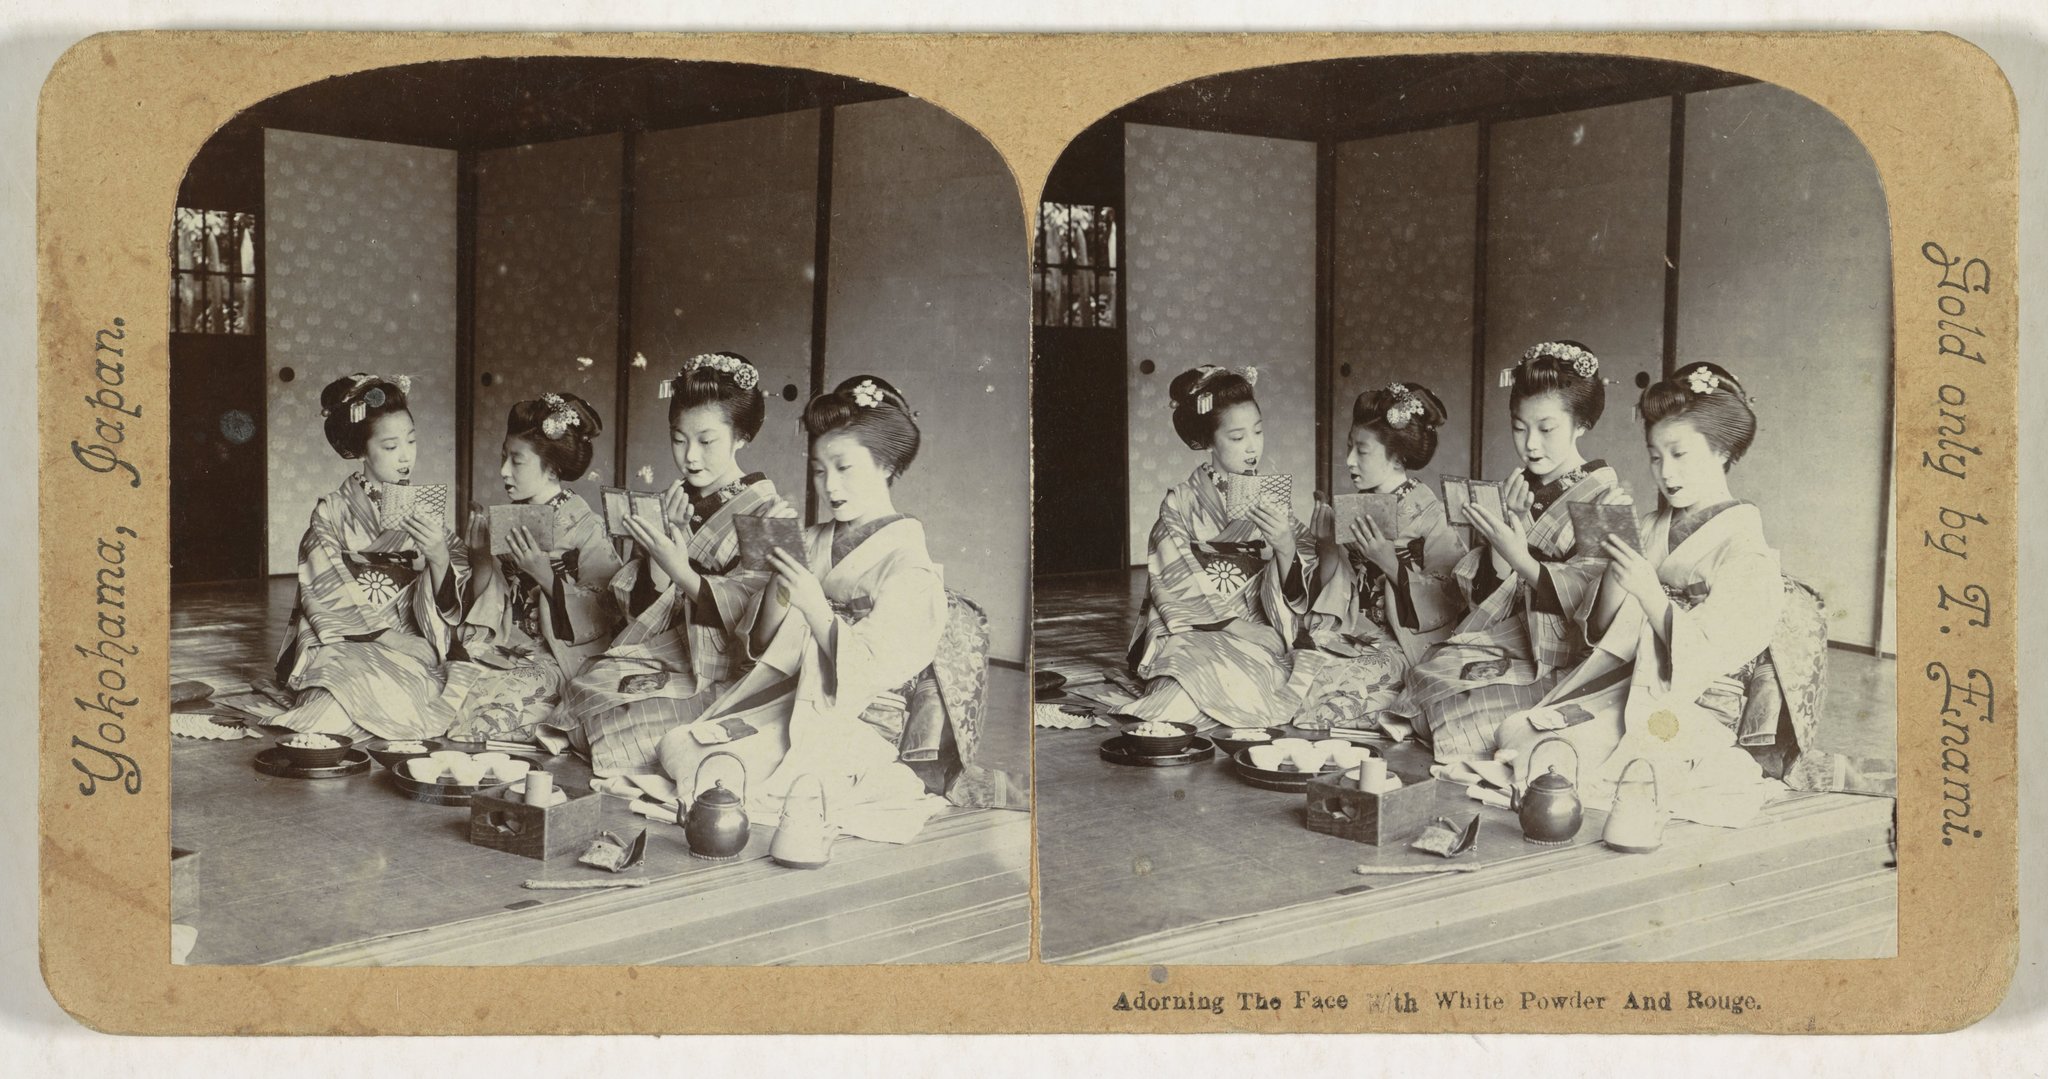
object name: stereograph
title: Adorning The Face With White Powder And Rouge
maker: t. enami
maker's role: publisher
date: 1900-1907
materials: paper, cardboard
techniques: gelatin silver print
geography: yokohama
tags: making up - aa - (for) women, japan